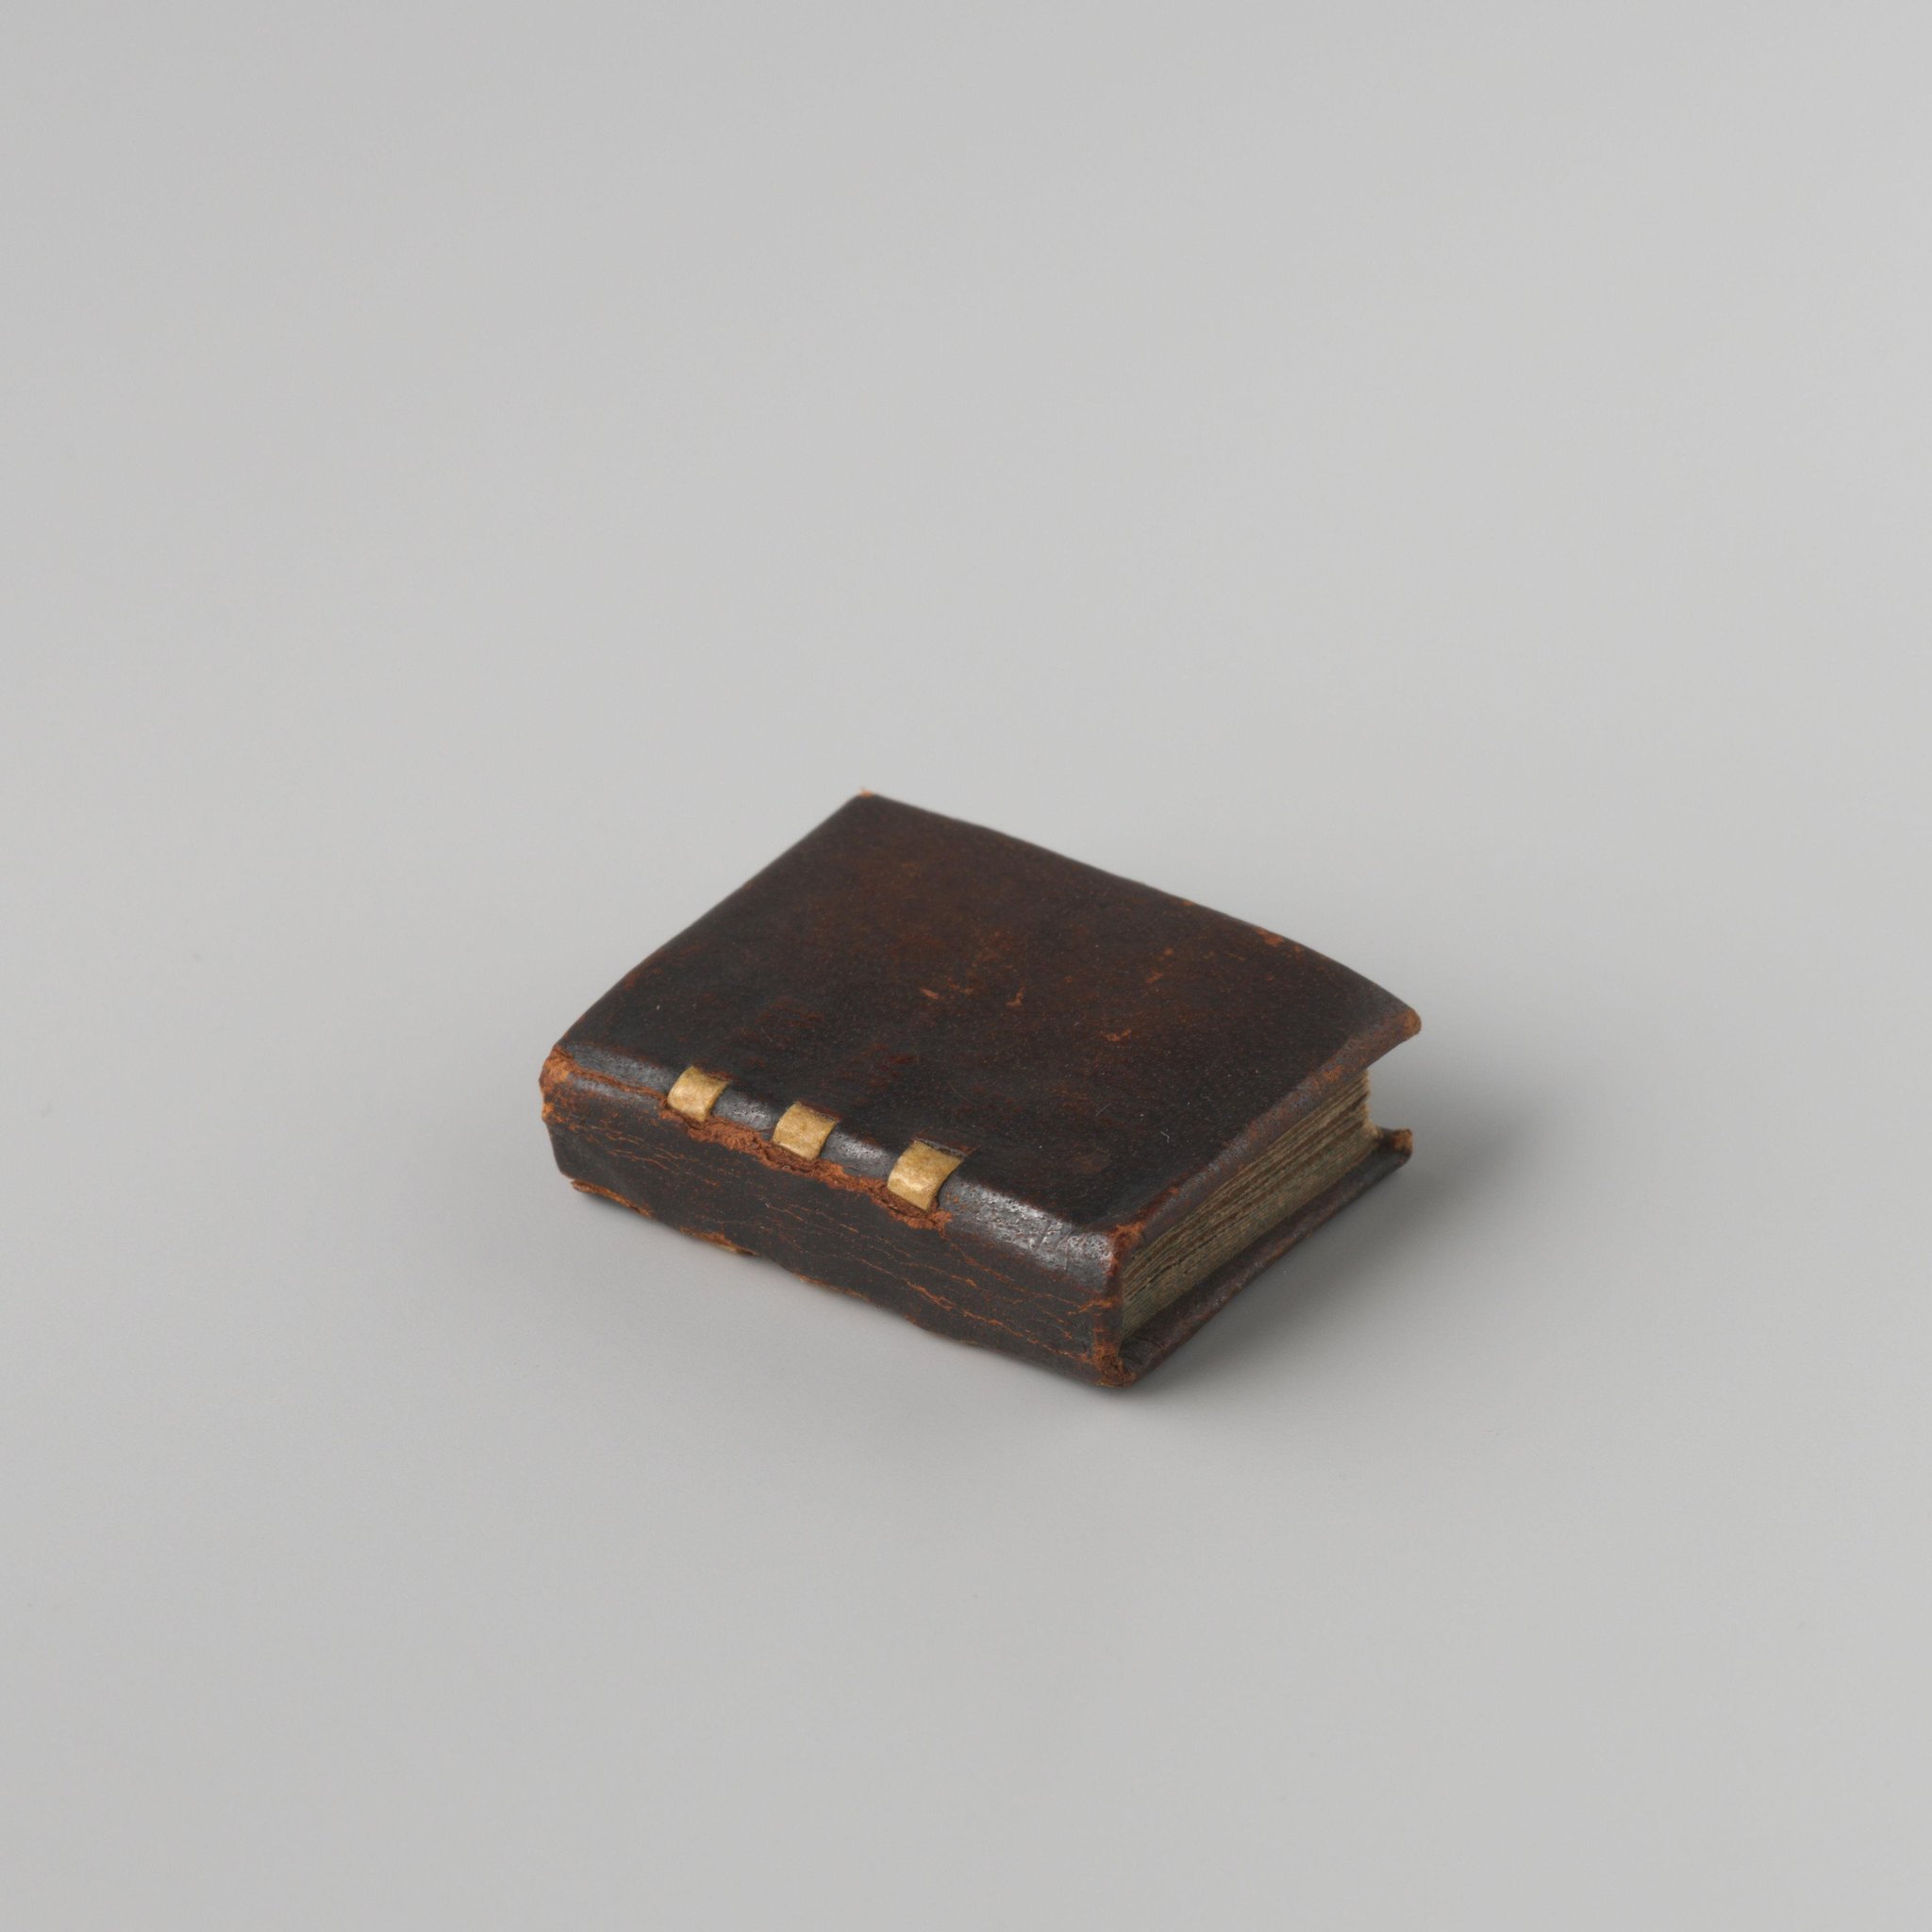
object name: book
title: Boek met stads- en tuingezichten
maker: Anonymous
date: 1690-1710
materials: leather, paper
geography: amsterdam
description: Boek met stads- en tuingezichten. Ingebonden in leer.